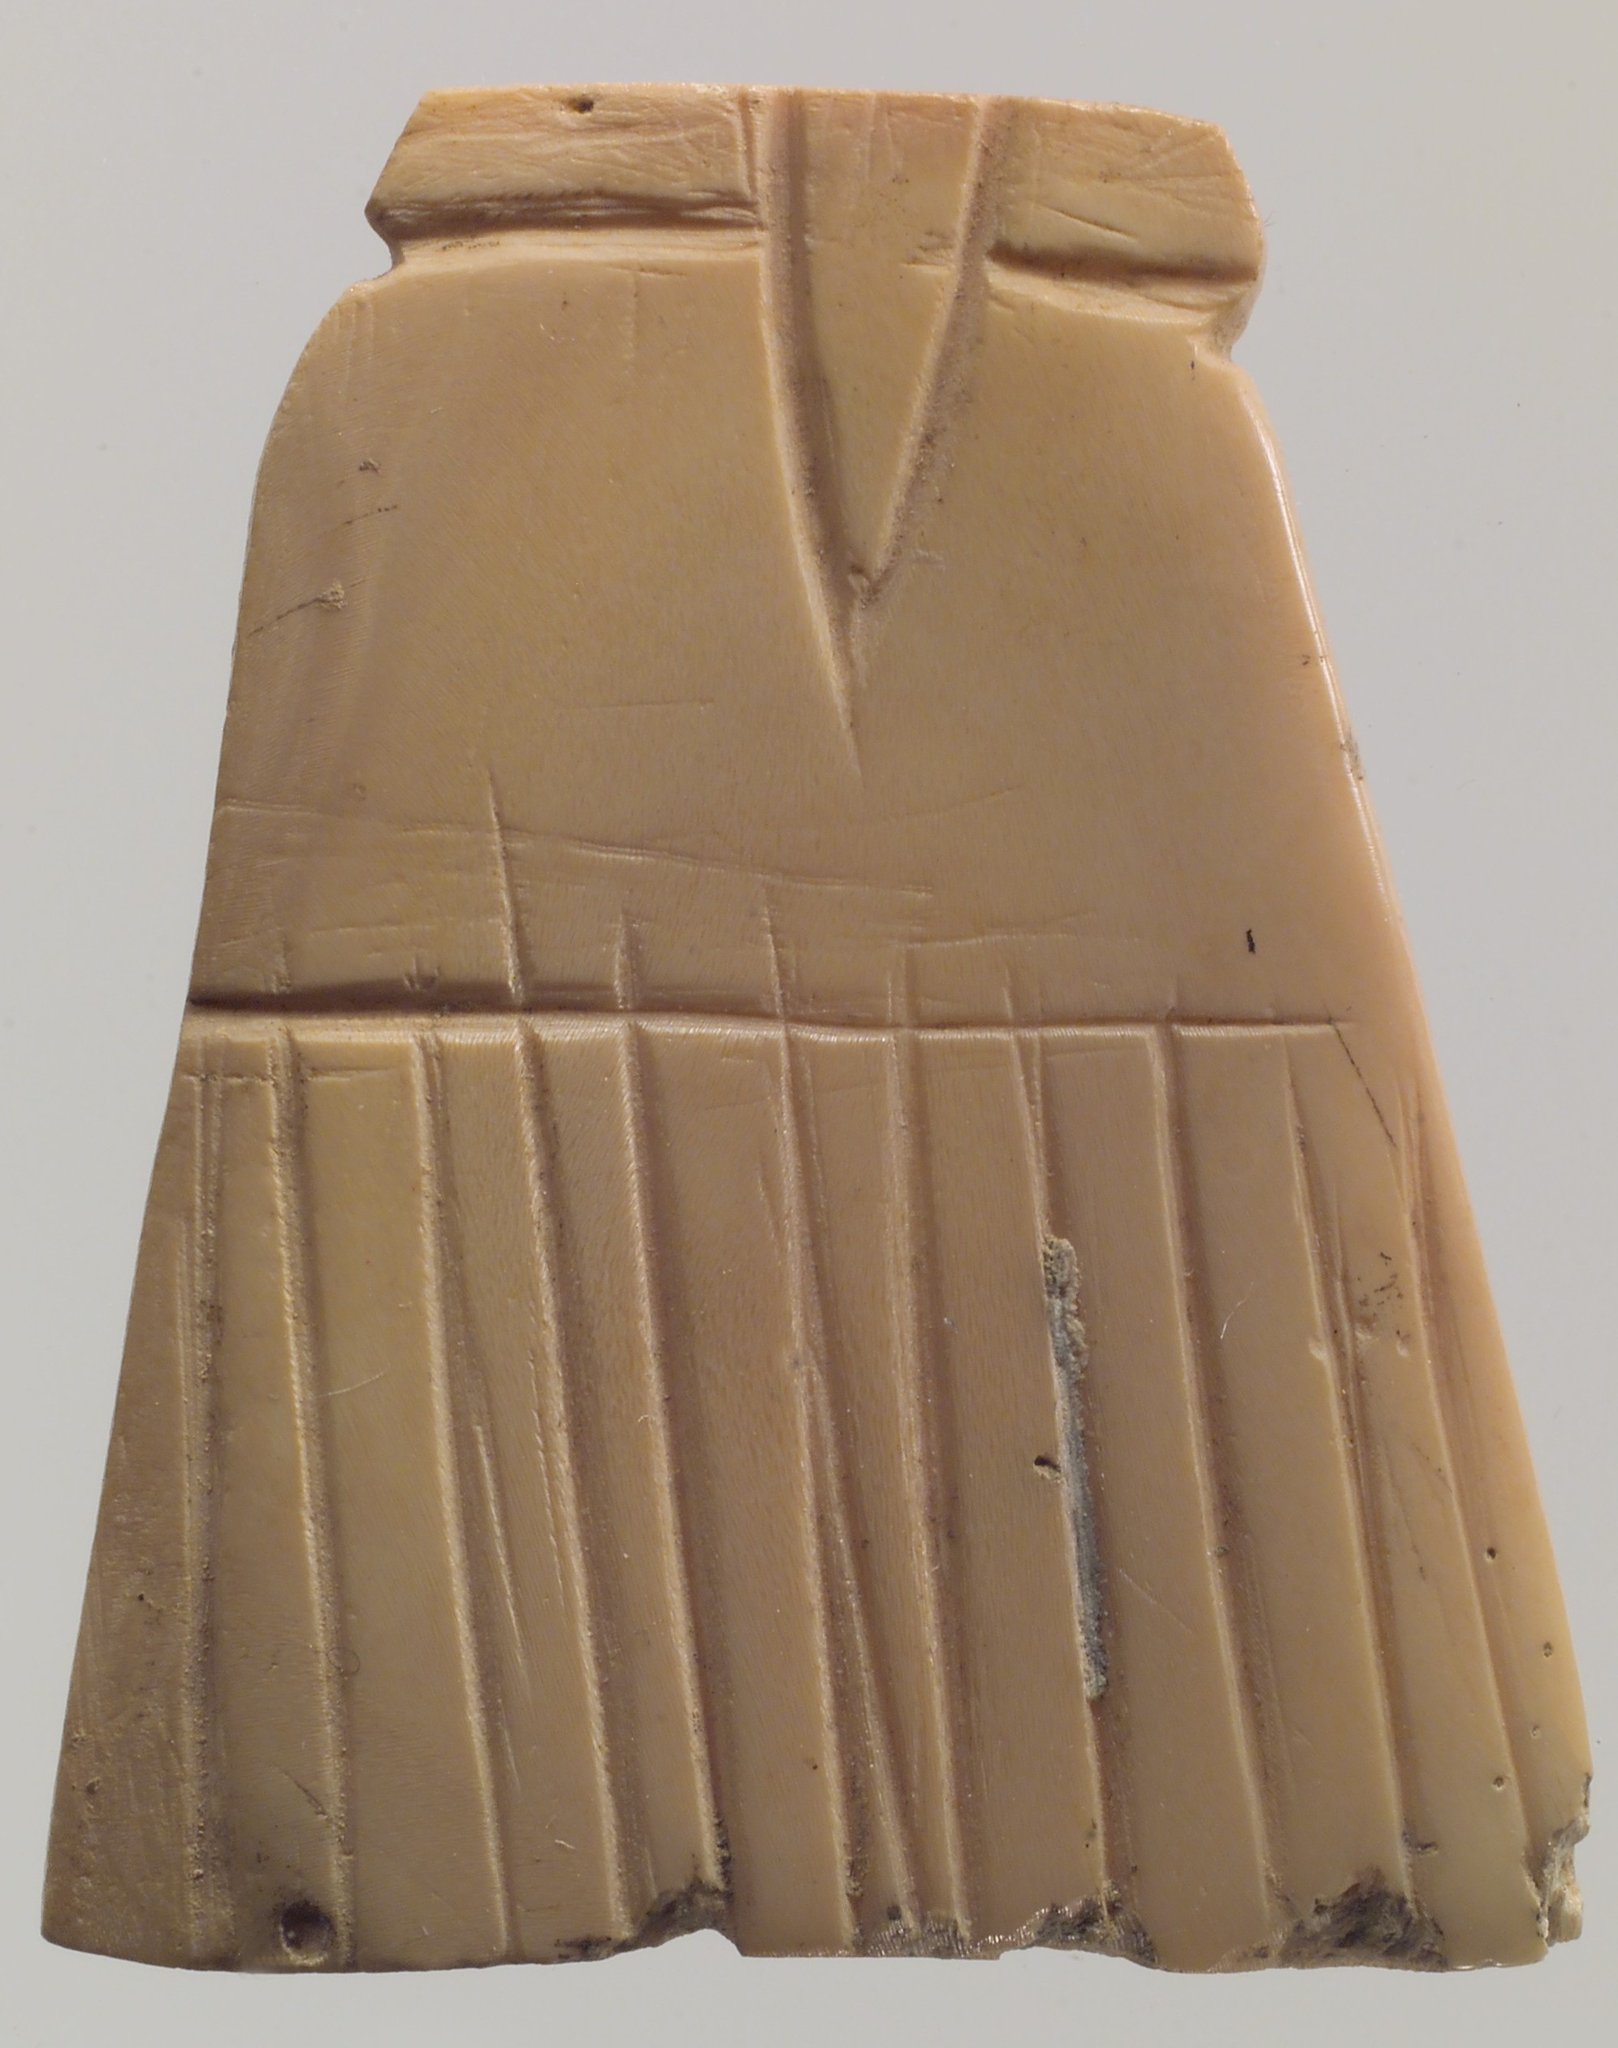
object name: inlay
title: Inlay: skirt with fringe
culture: sumerian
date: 2600-2500 BCE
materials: shell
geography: mesopotamia